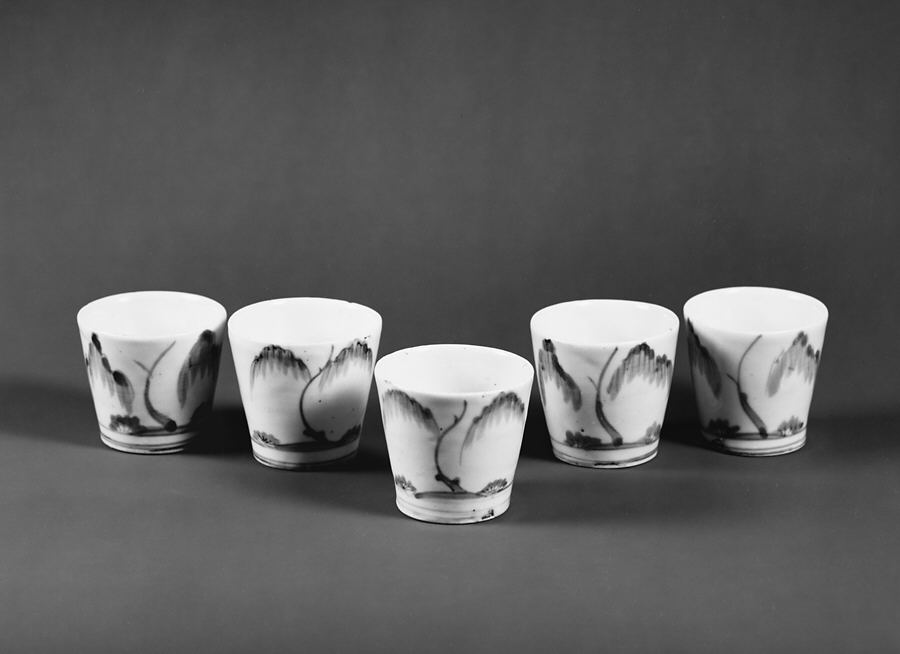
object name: soba cup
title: Soba Cup with Design of Willows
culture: japanese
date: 1667-1733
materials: porcelain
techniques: underglaze